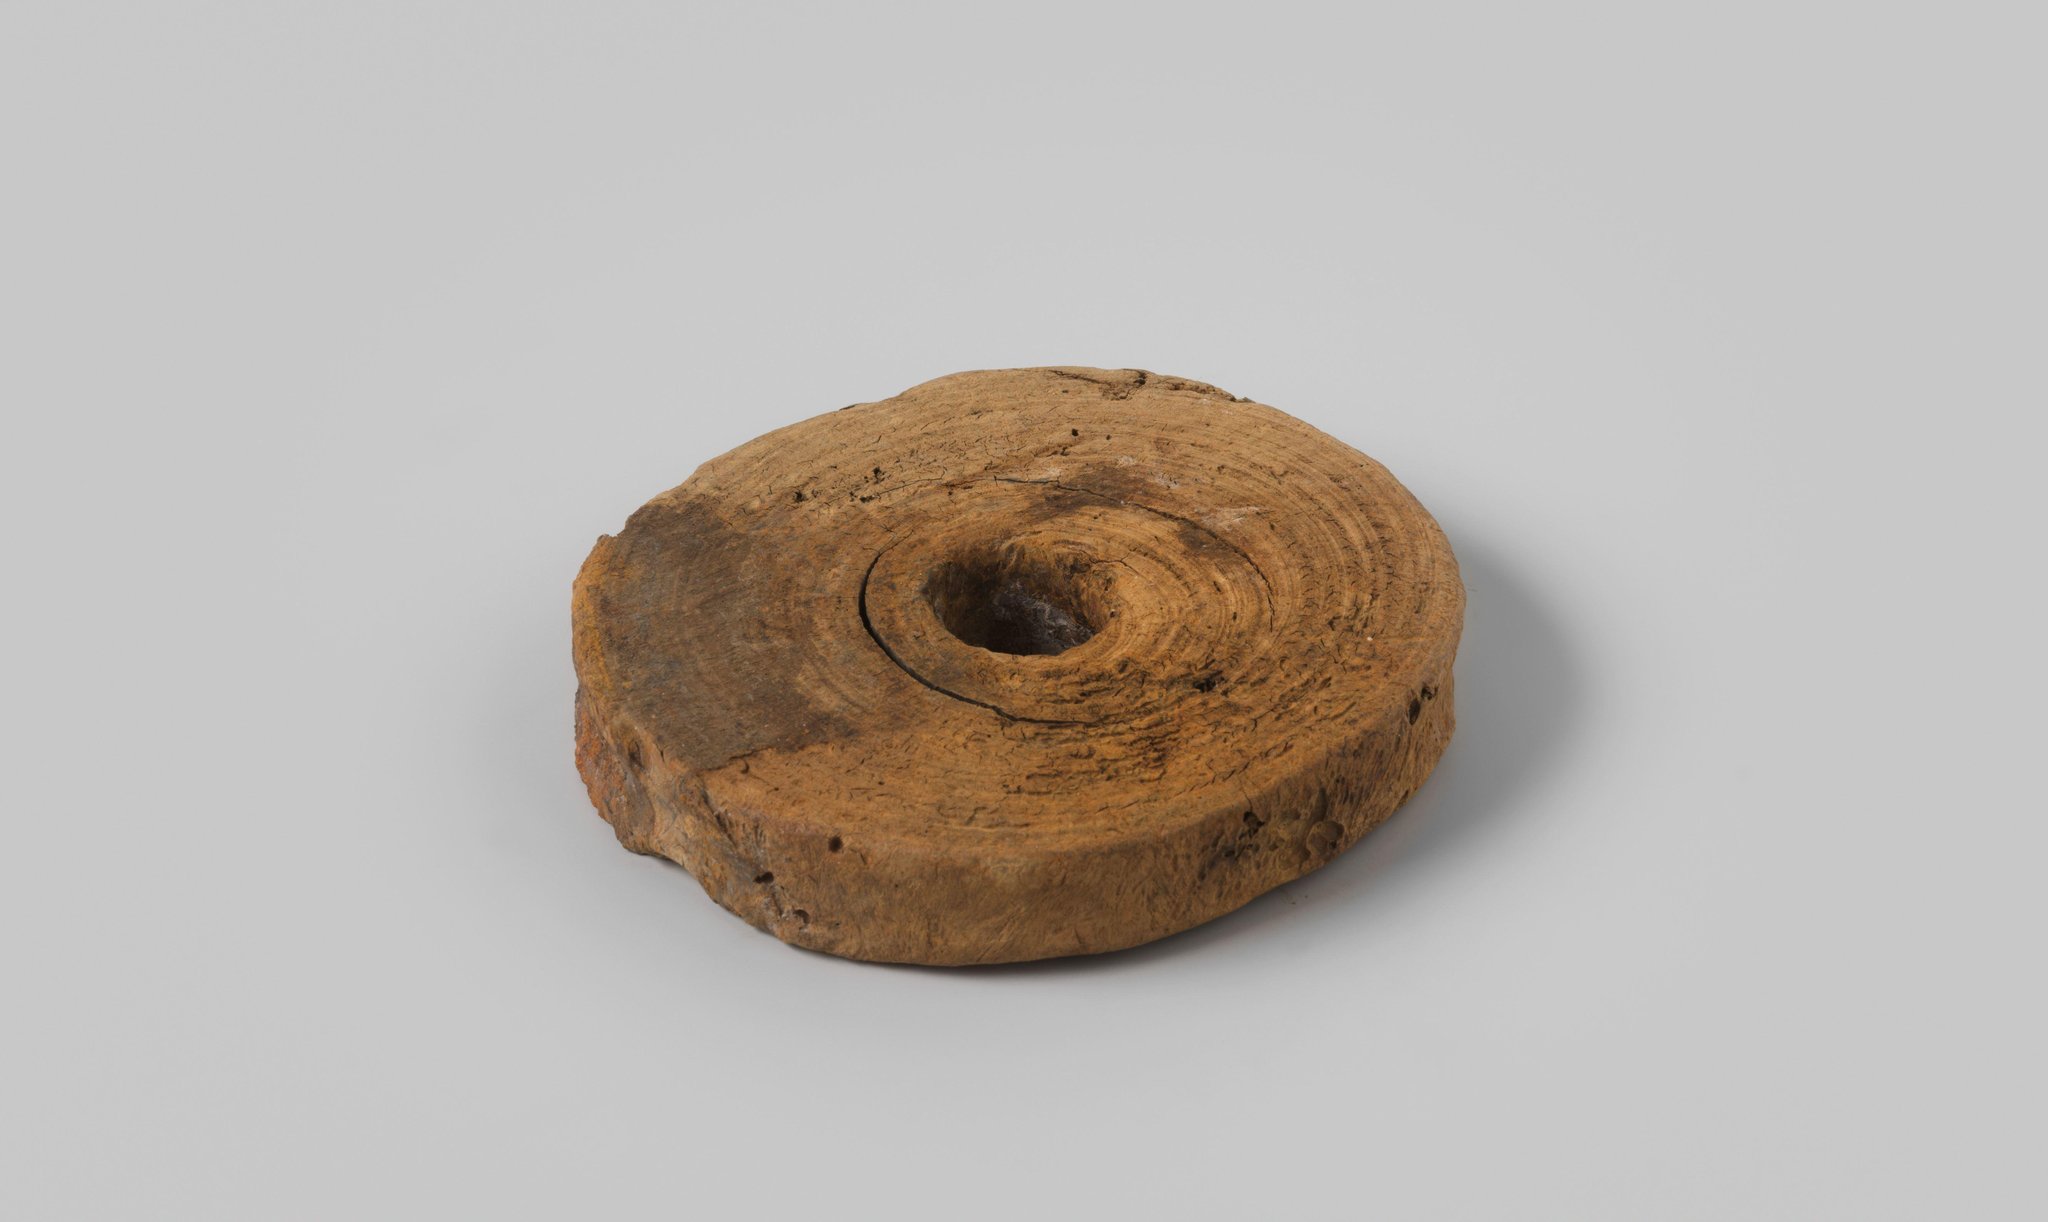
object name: disk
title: Schijf van katrol uit het wrak van de Oost-Indiëvaarder Hollandia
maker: Anonymous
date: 1700-1743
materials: wood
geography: netherlands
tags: verenigde oostindische compagnie, hollandia (schip), annet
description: Block, sheave; eroded, sim. NG 1979-256H3096.